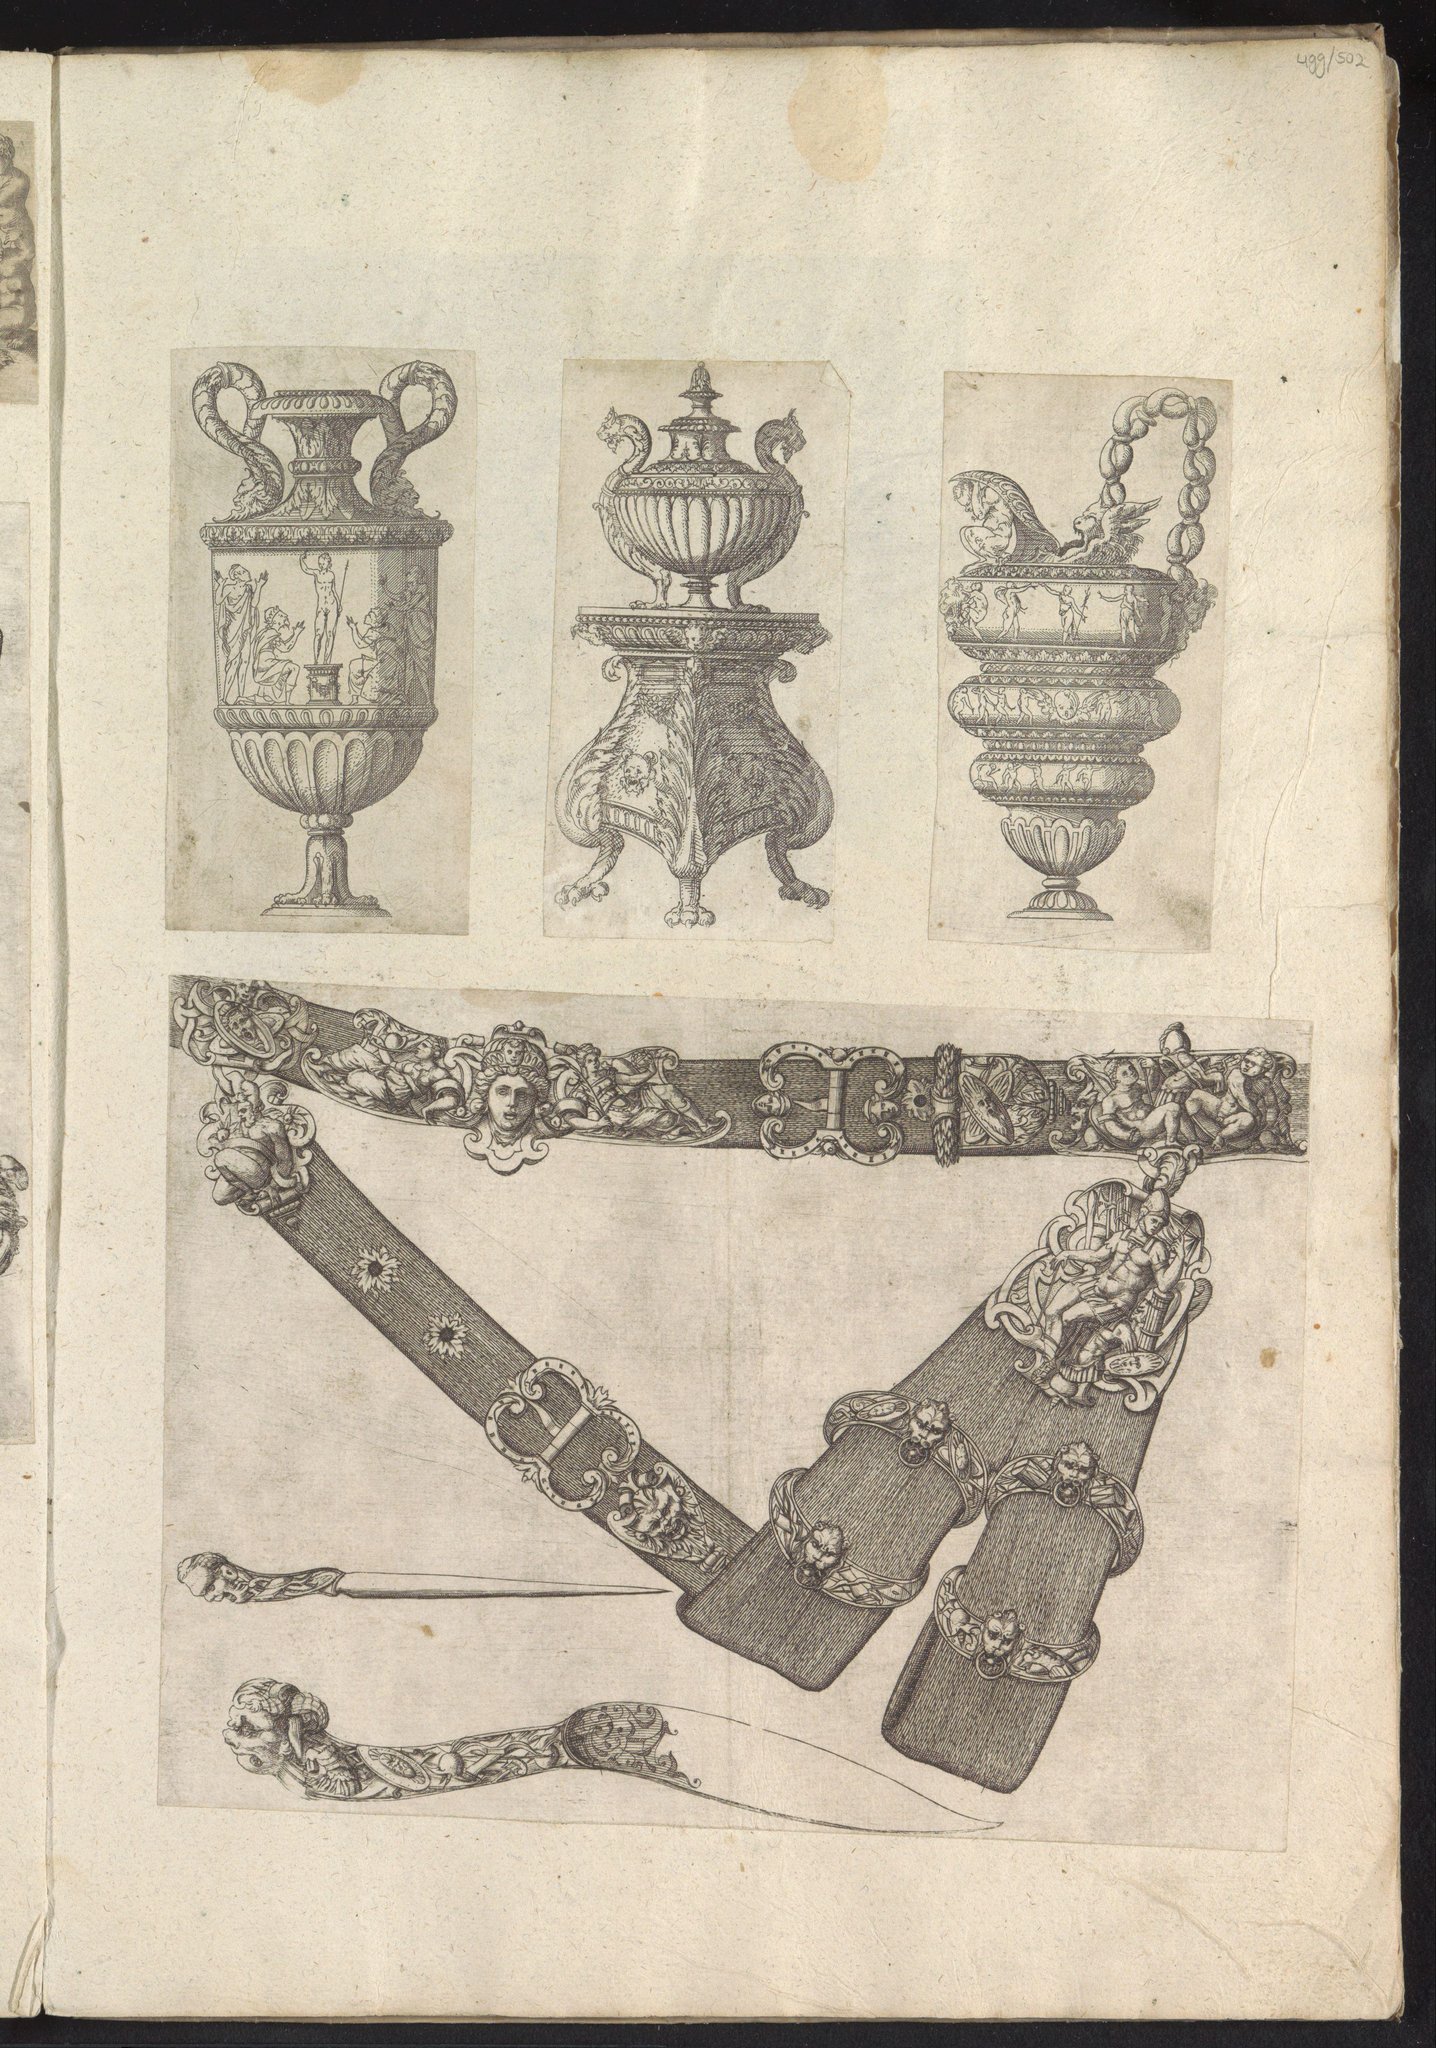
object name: album leaf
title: Albumblad met vier prenten met twee vazen, een kan en een holster voor een zwaard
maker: Anonymous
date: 1500-1599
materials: paper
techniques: engraving, etching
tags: kitchen-utensils: cauldron, ornaments ~ art, parts of hacking and thrusting weapons: grip, vase ~ ornament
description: Albumblad met vier uitgeknipte prenten: twee vazen, een kan en een holster voor een zwaard met daarnaast twee dolken.